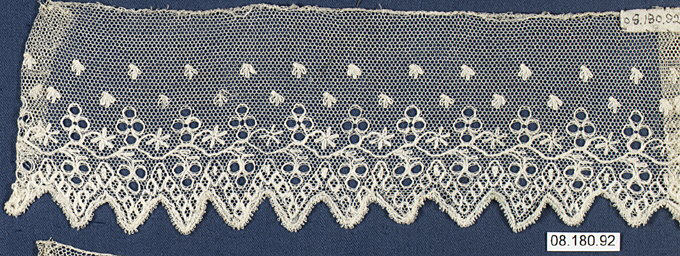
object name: fragment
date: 1801-1900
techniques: lace